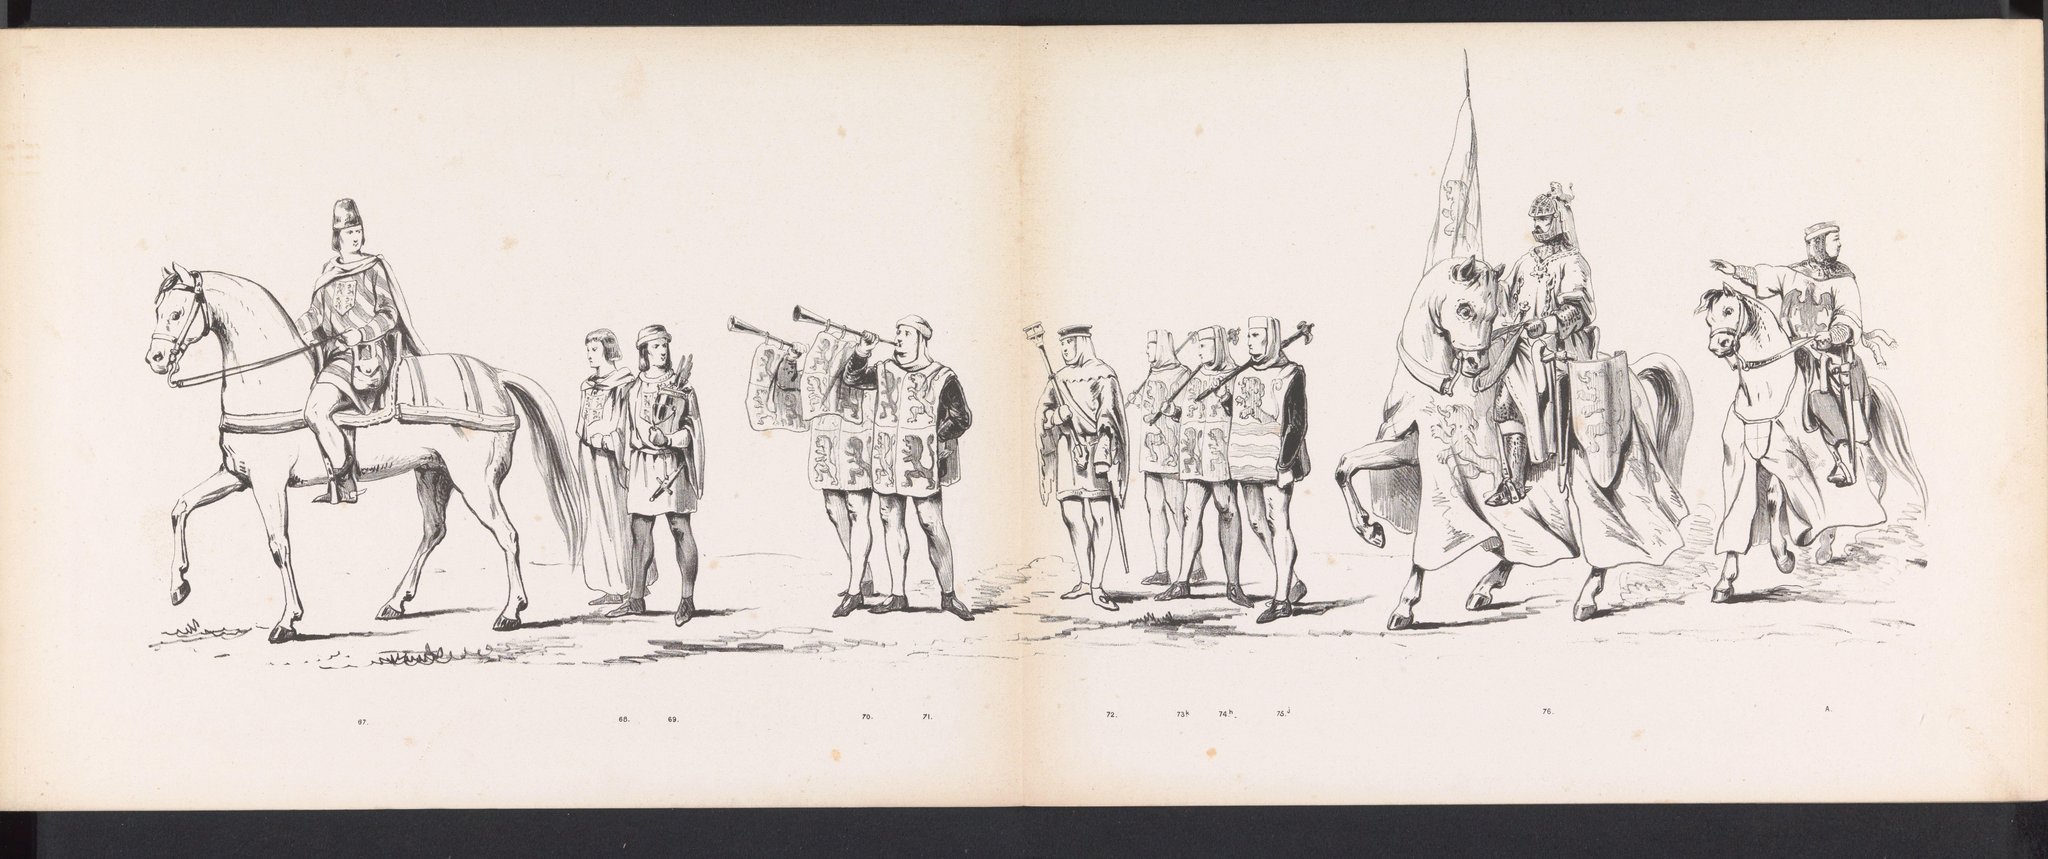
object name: print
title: Gecostumeerde optogt gehouden door de leden van het Leidsche studenten-corps den 6den Junij 1865, ter viering van den 290sten verjaardag der Leidsche Hoogeschool, voorstellende: de intogt der Hollanders binnen Zierikzee onder Jonker Willem, Grave van Oostervant, op den 12den augustus Anno 1304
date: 1865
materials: paper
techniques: lithograph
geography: leiden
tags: students' pageant, costumes used in pageants, leiden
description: Historische gekostumeerde optocht van de studenten van de Leidse Hogeschool gehouden op 6 juni 1865 ter gelegenheid van het 290-jarig bestaan van de Hogeschool. De optocht verbeeldt de intocht van de Hollanders binnen Zierikzee op 12 augustus 1304. Zesde plaat met de groepen genummerd 67-76. Onderdeel van de serie van 16 aaneen geplakte bladen.